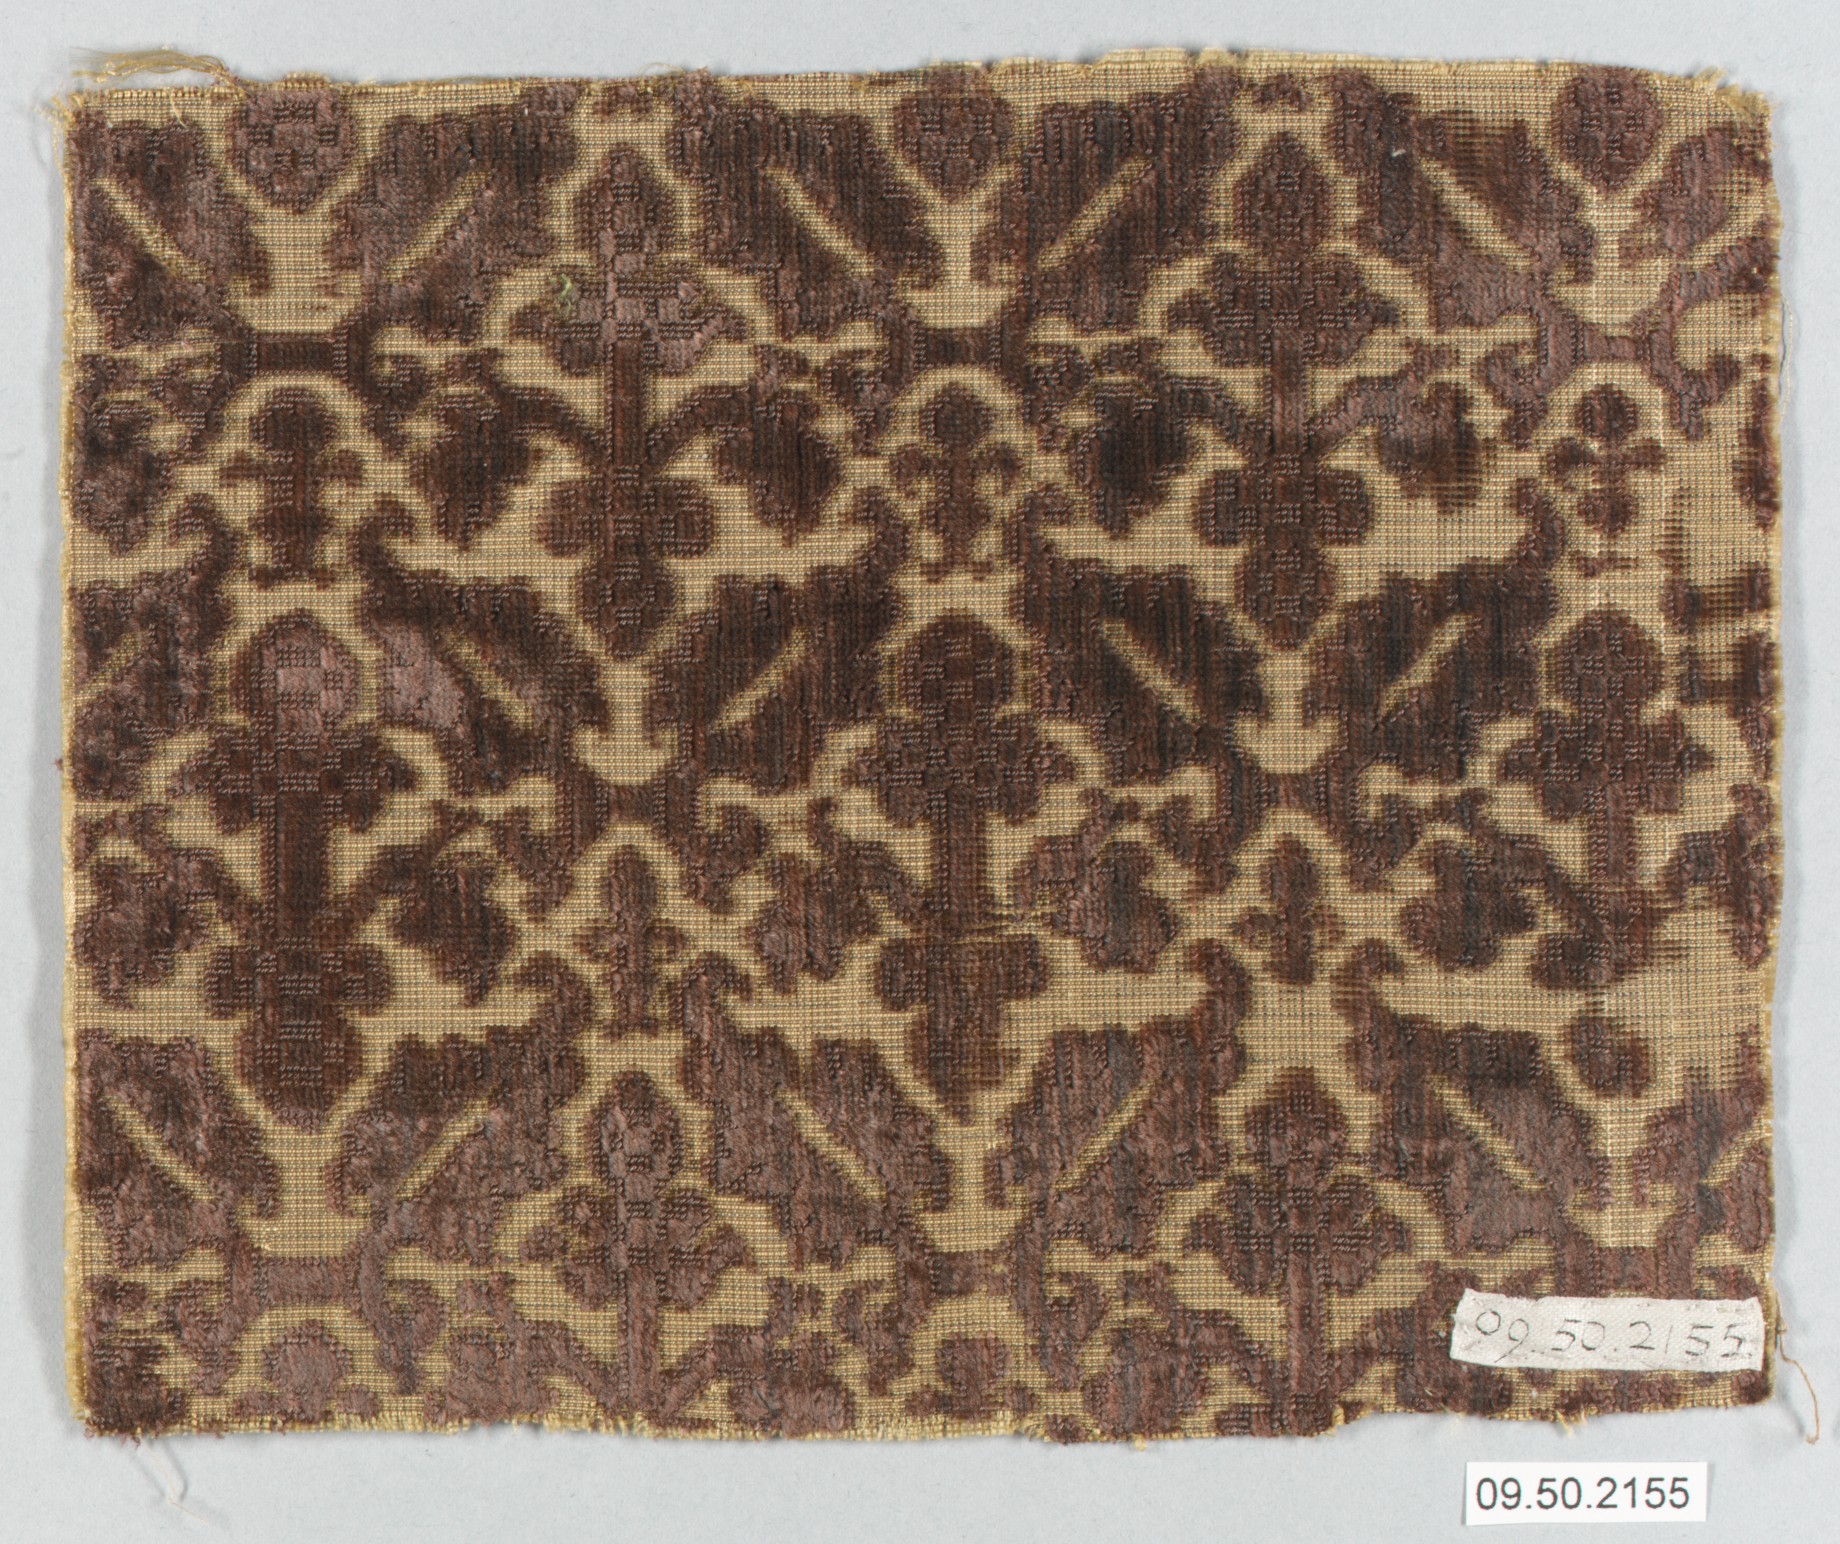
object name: piece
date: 1501-1700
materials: metal thread, silk